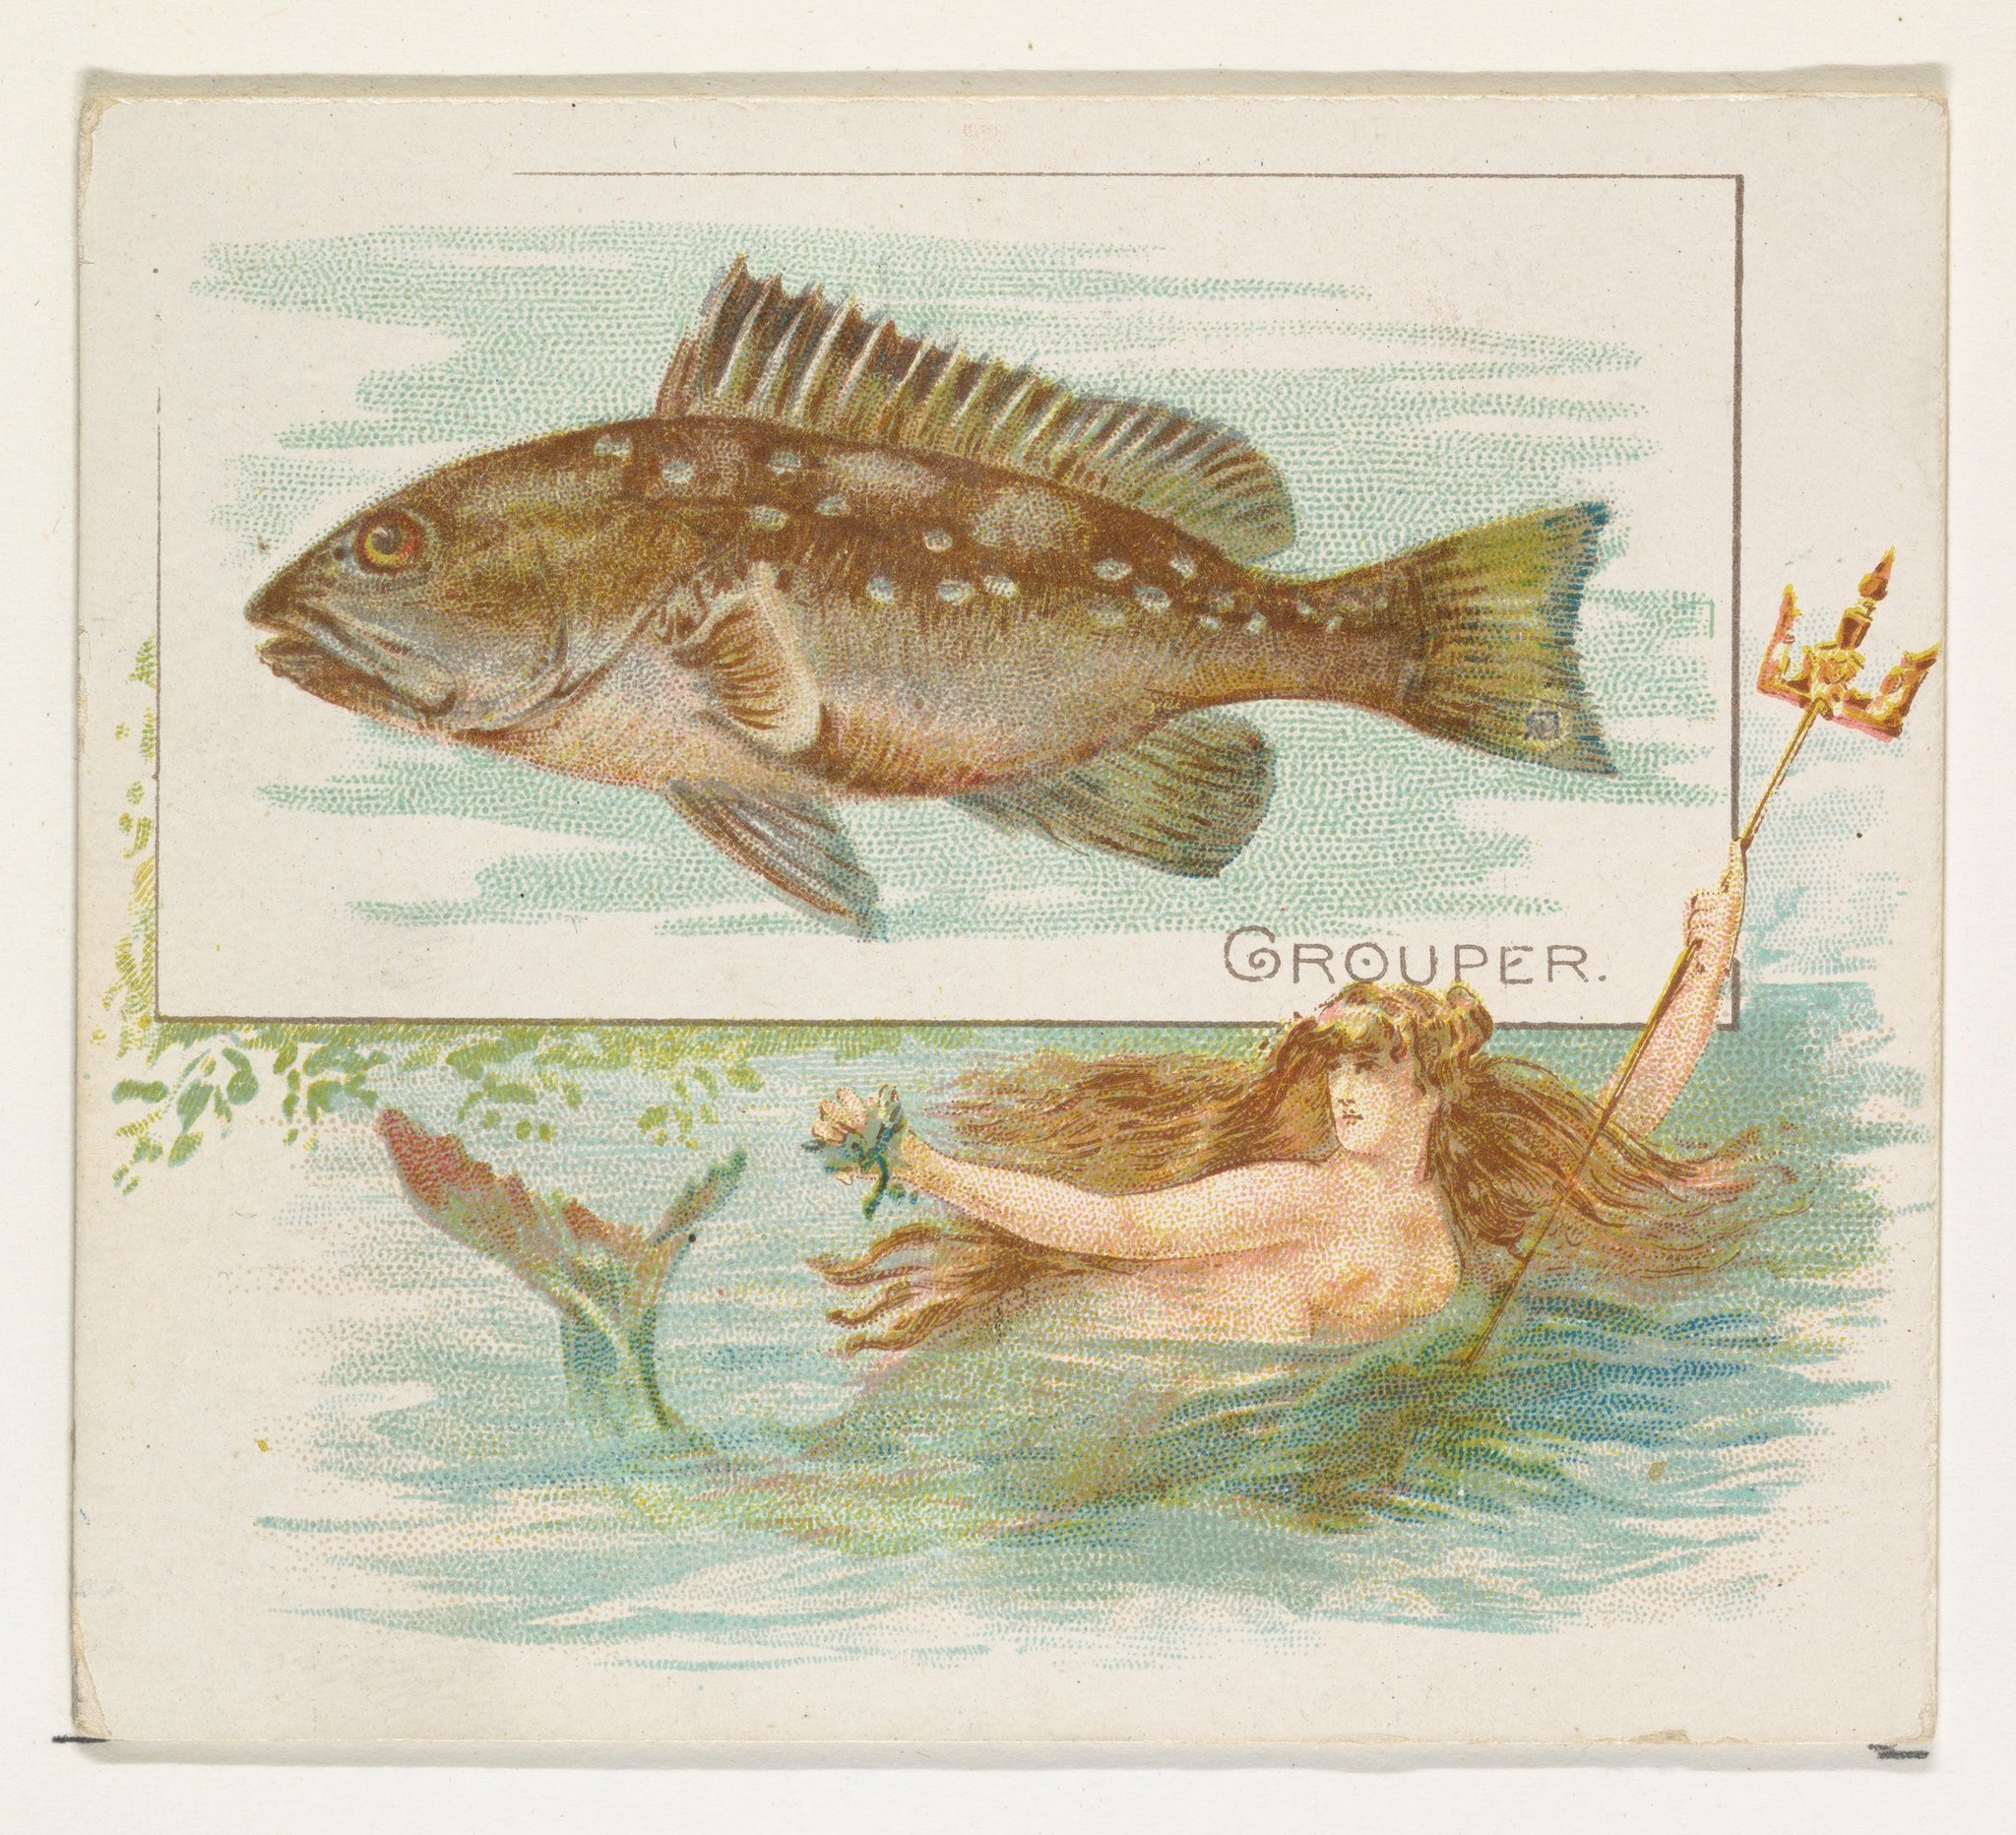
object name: print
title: Grouper, from Fish from American Waters series (N39) for Allen & Ginter Cigarettes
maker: allen & ginter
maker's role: publisher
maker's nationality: american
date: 1889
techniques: color lithograph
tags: mermaids,fish